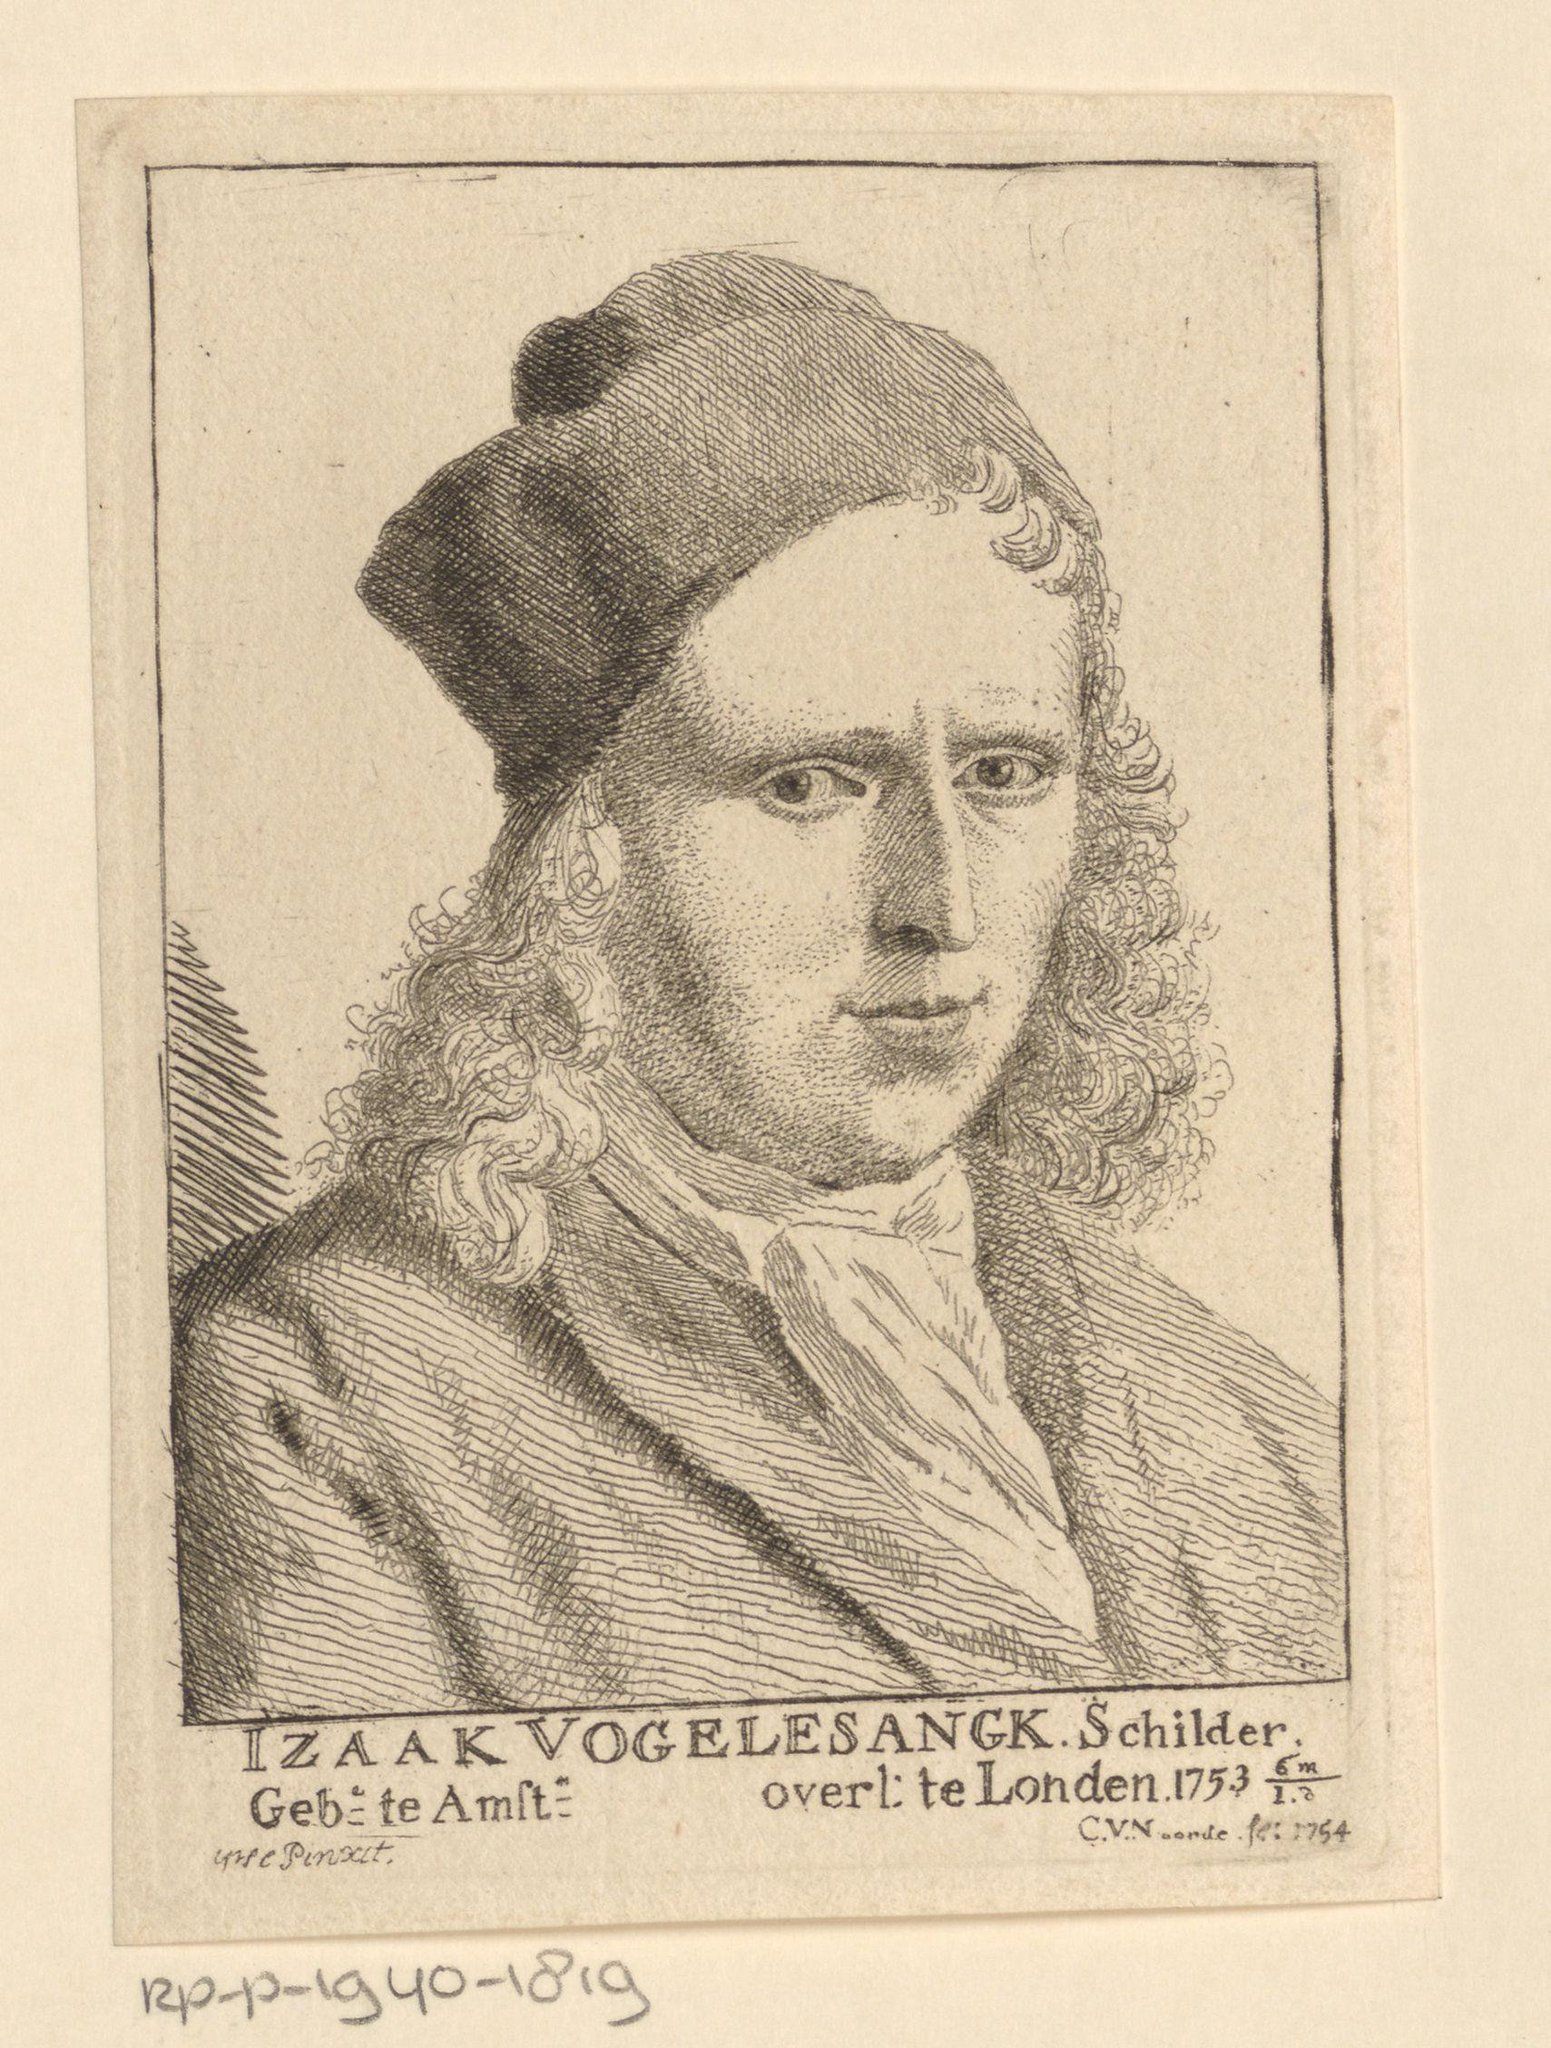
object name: print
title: Portret van Izaak Vogelensanck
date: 1754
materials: paper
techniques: etching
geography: haarlem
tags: amsterdam, london, painter, izaak vogelensanck, historical persons, portrait, self-portrait of painter, portrait, self-portrait of graphic artist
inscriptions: collector's mark: Lugt 2228, collector's mark: Lugt 2760